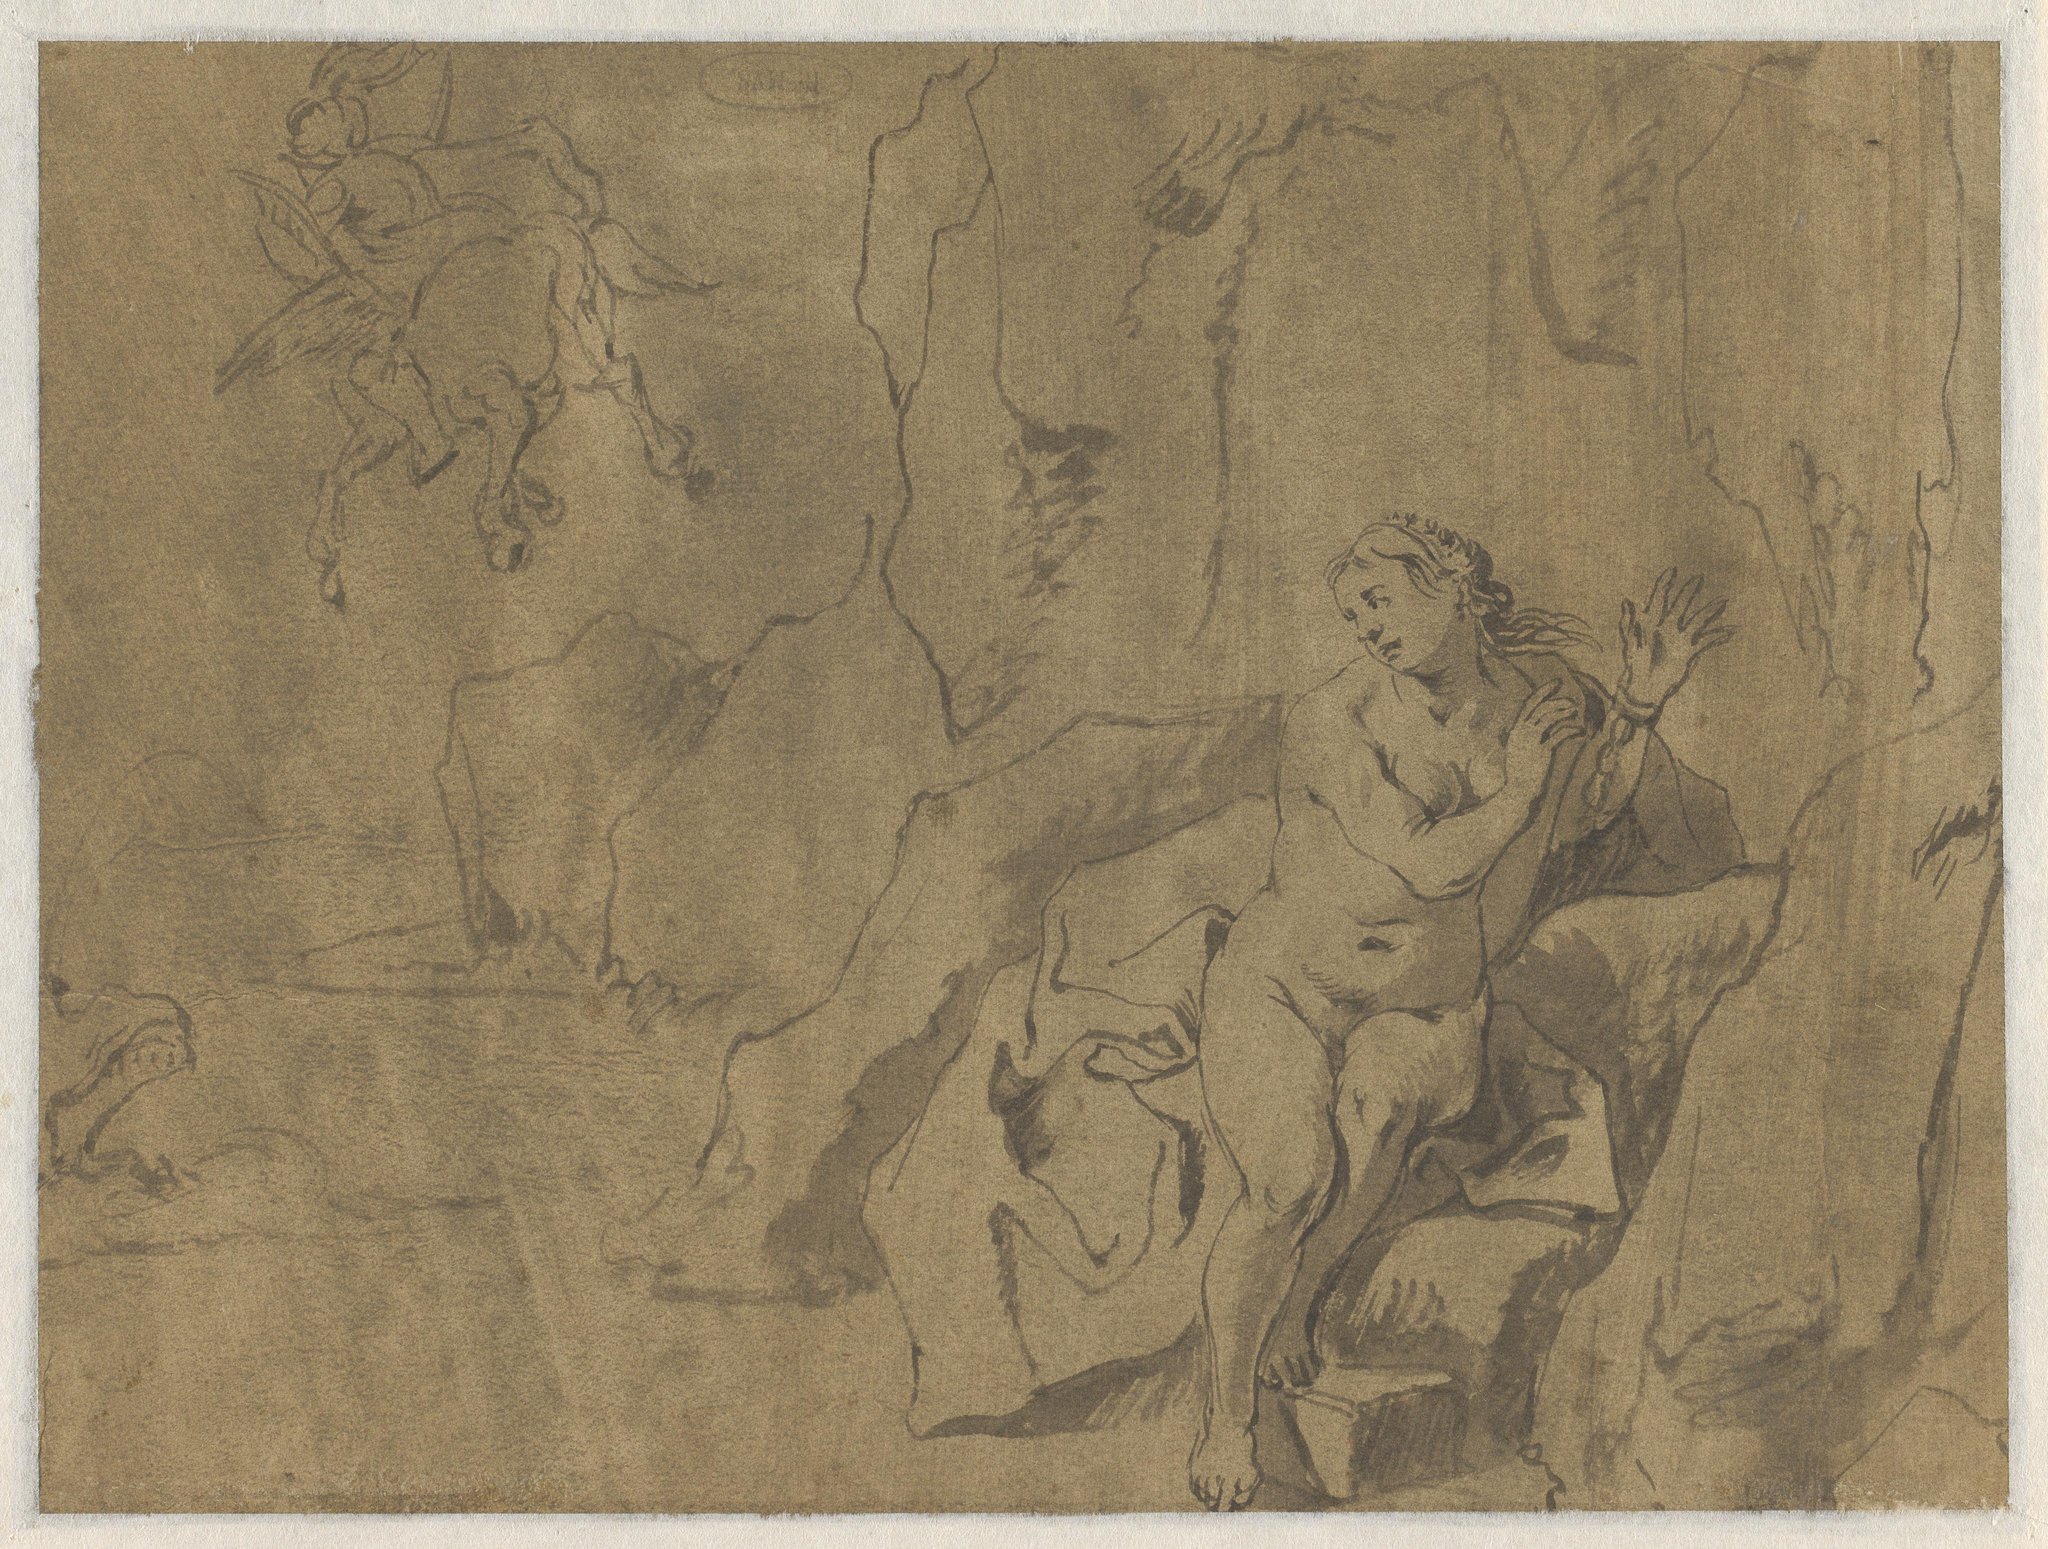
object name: drawing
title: Perseus en Andromeda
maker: leonaert bramer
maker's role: draughtsman, painter, print maker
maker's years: 1596-1674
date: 1606-1674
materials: ink, paper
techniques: brush, pen